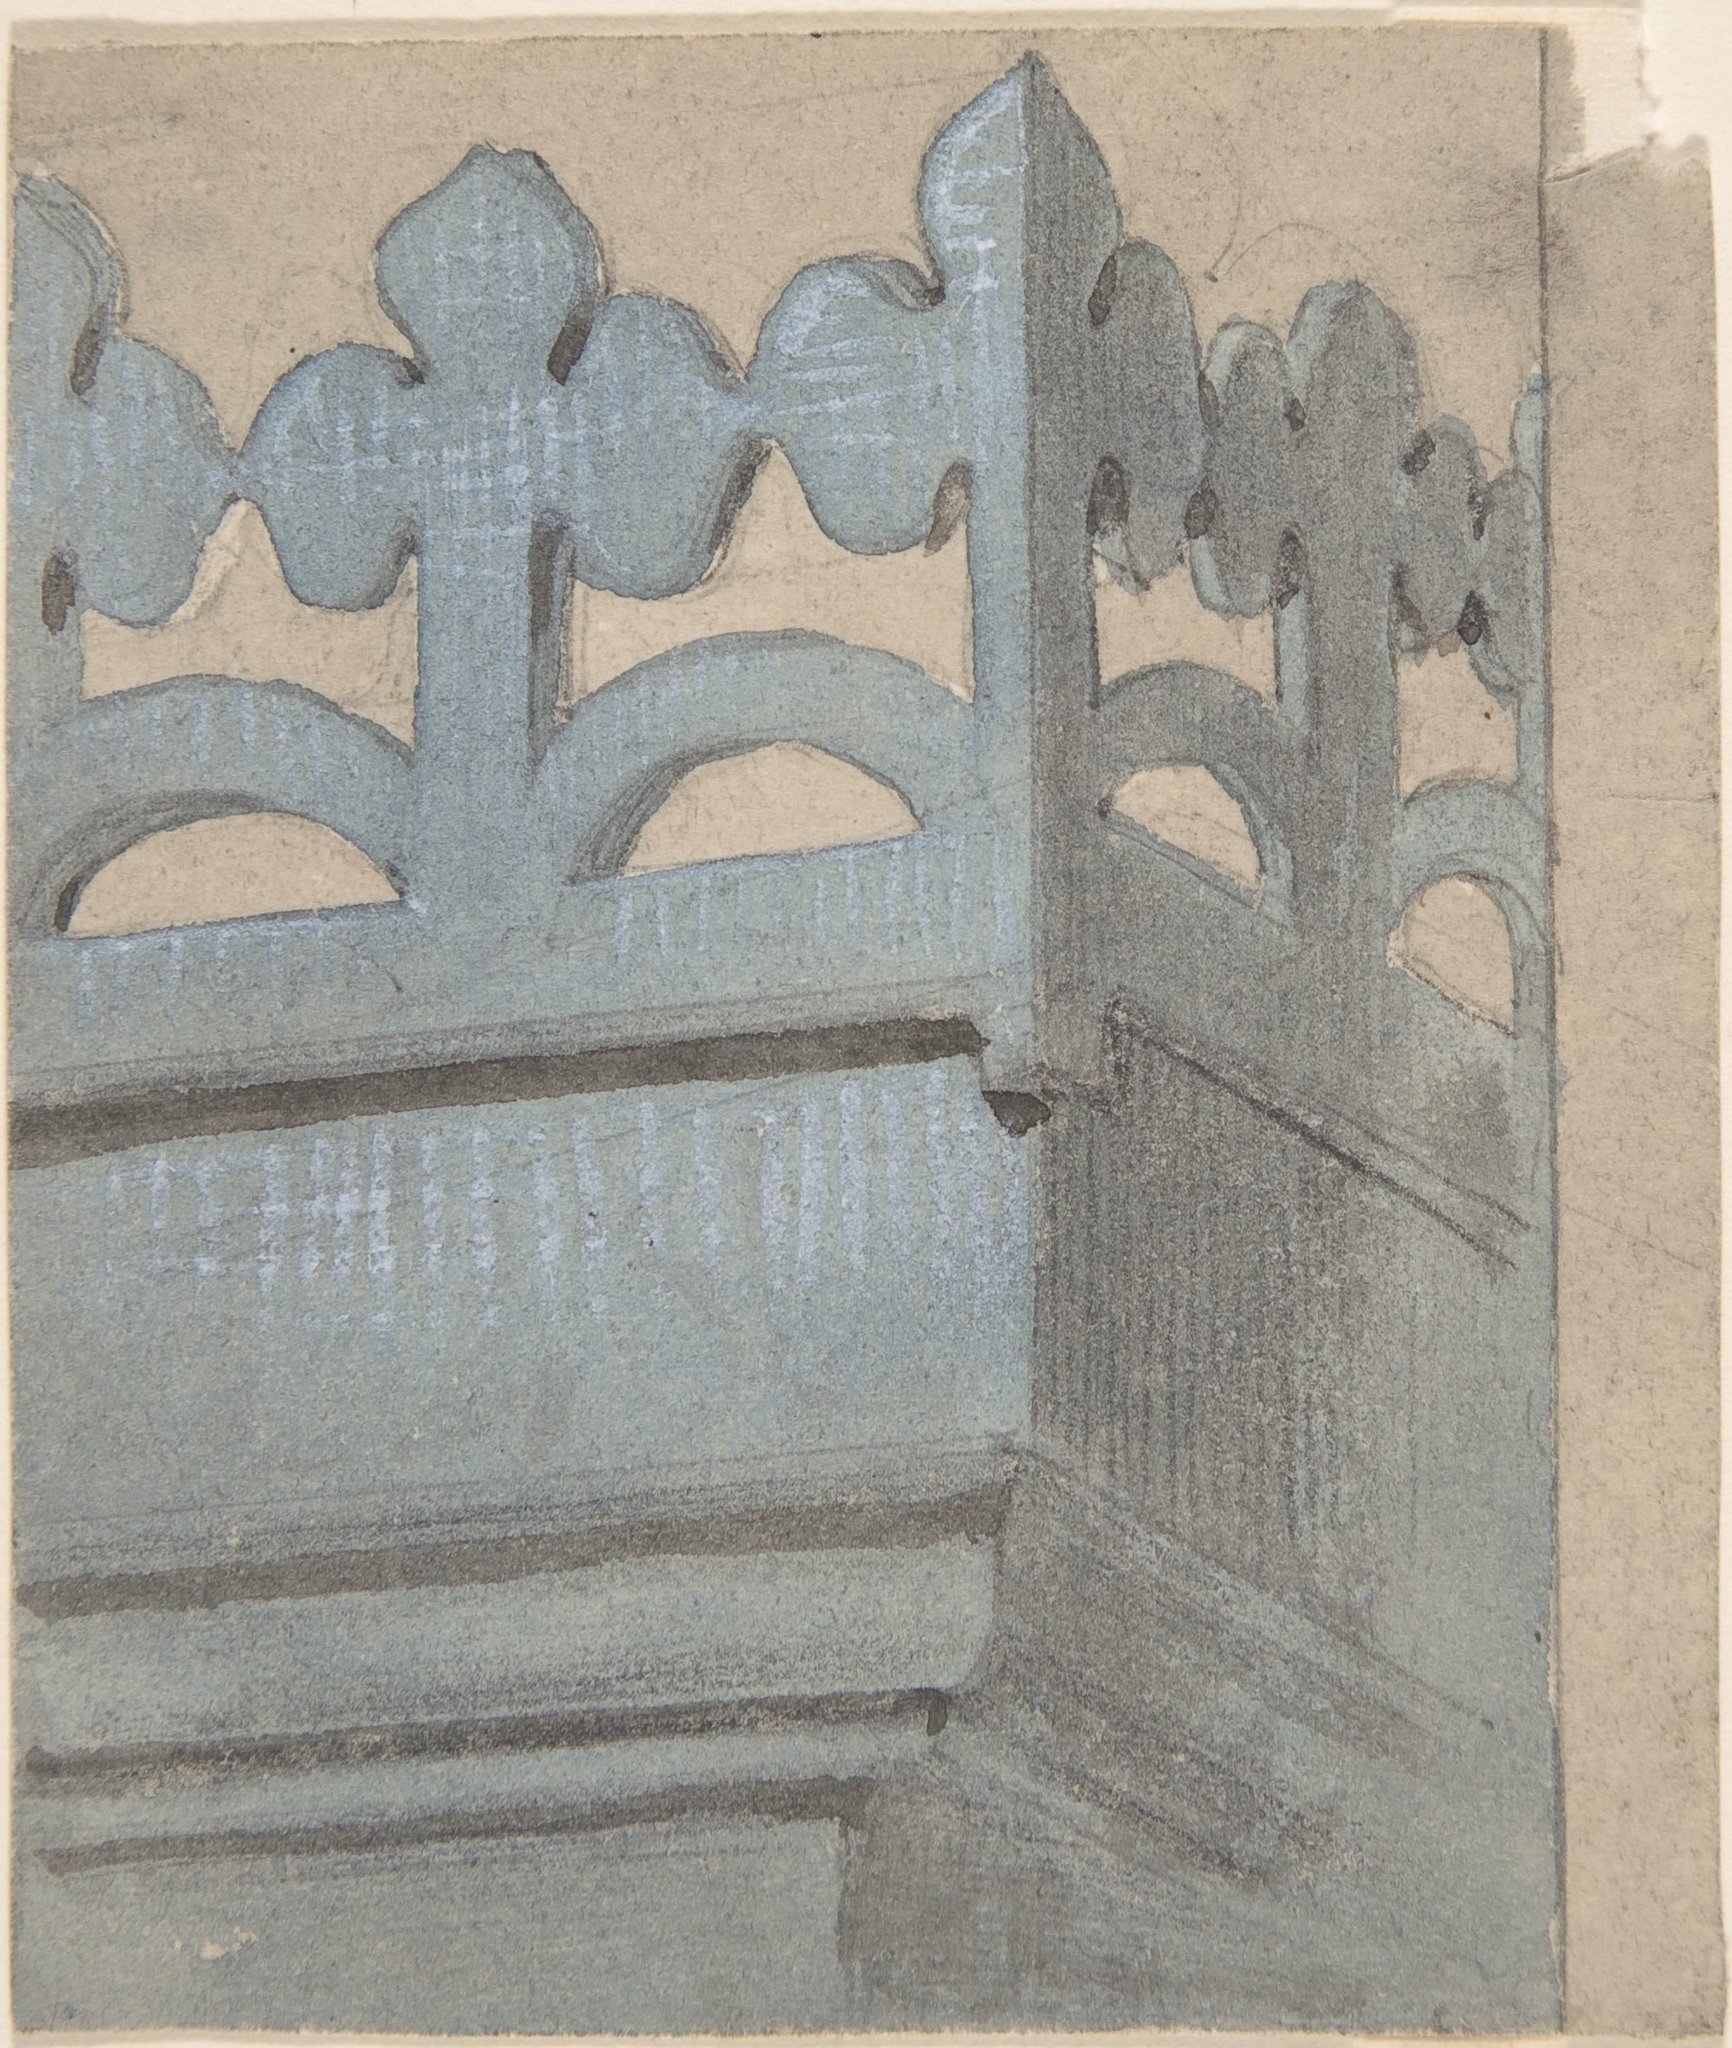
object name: drawing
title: Metal Ornament for Church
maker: anonymous, british, 19th century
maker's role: artist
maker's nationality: british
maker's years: 1800-1900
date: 1851-1900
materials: gouache